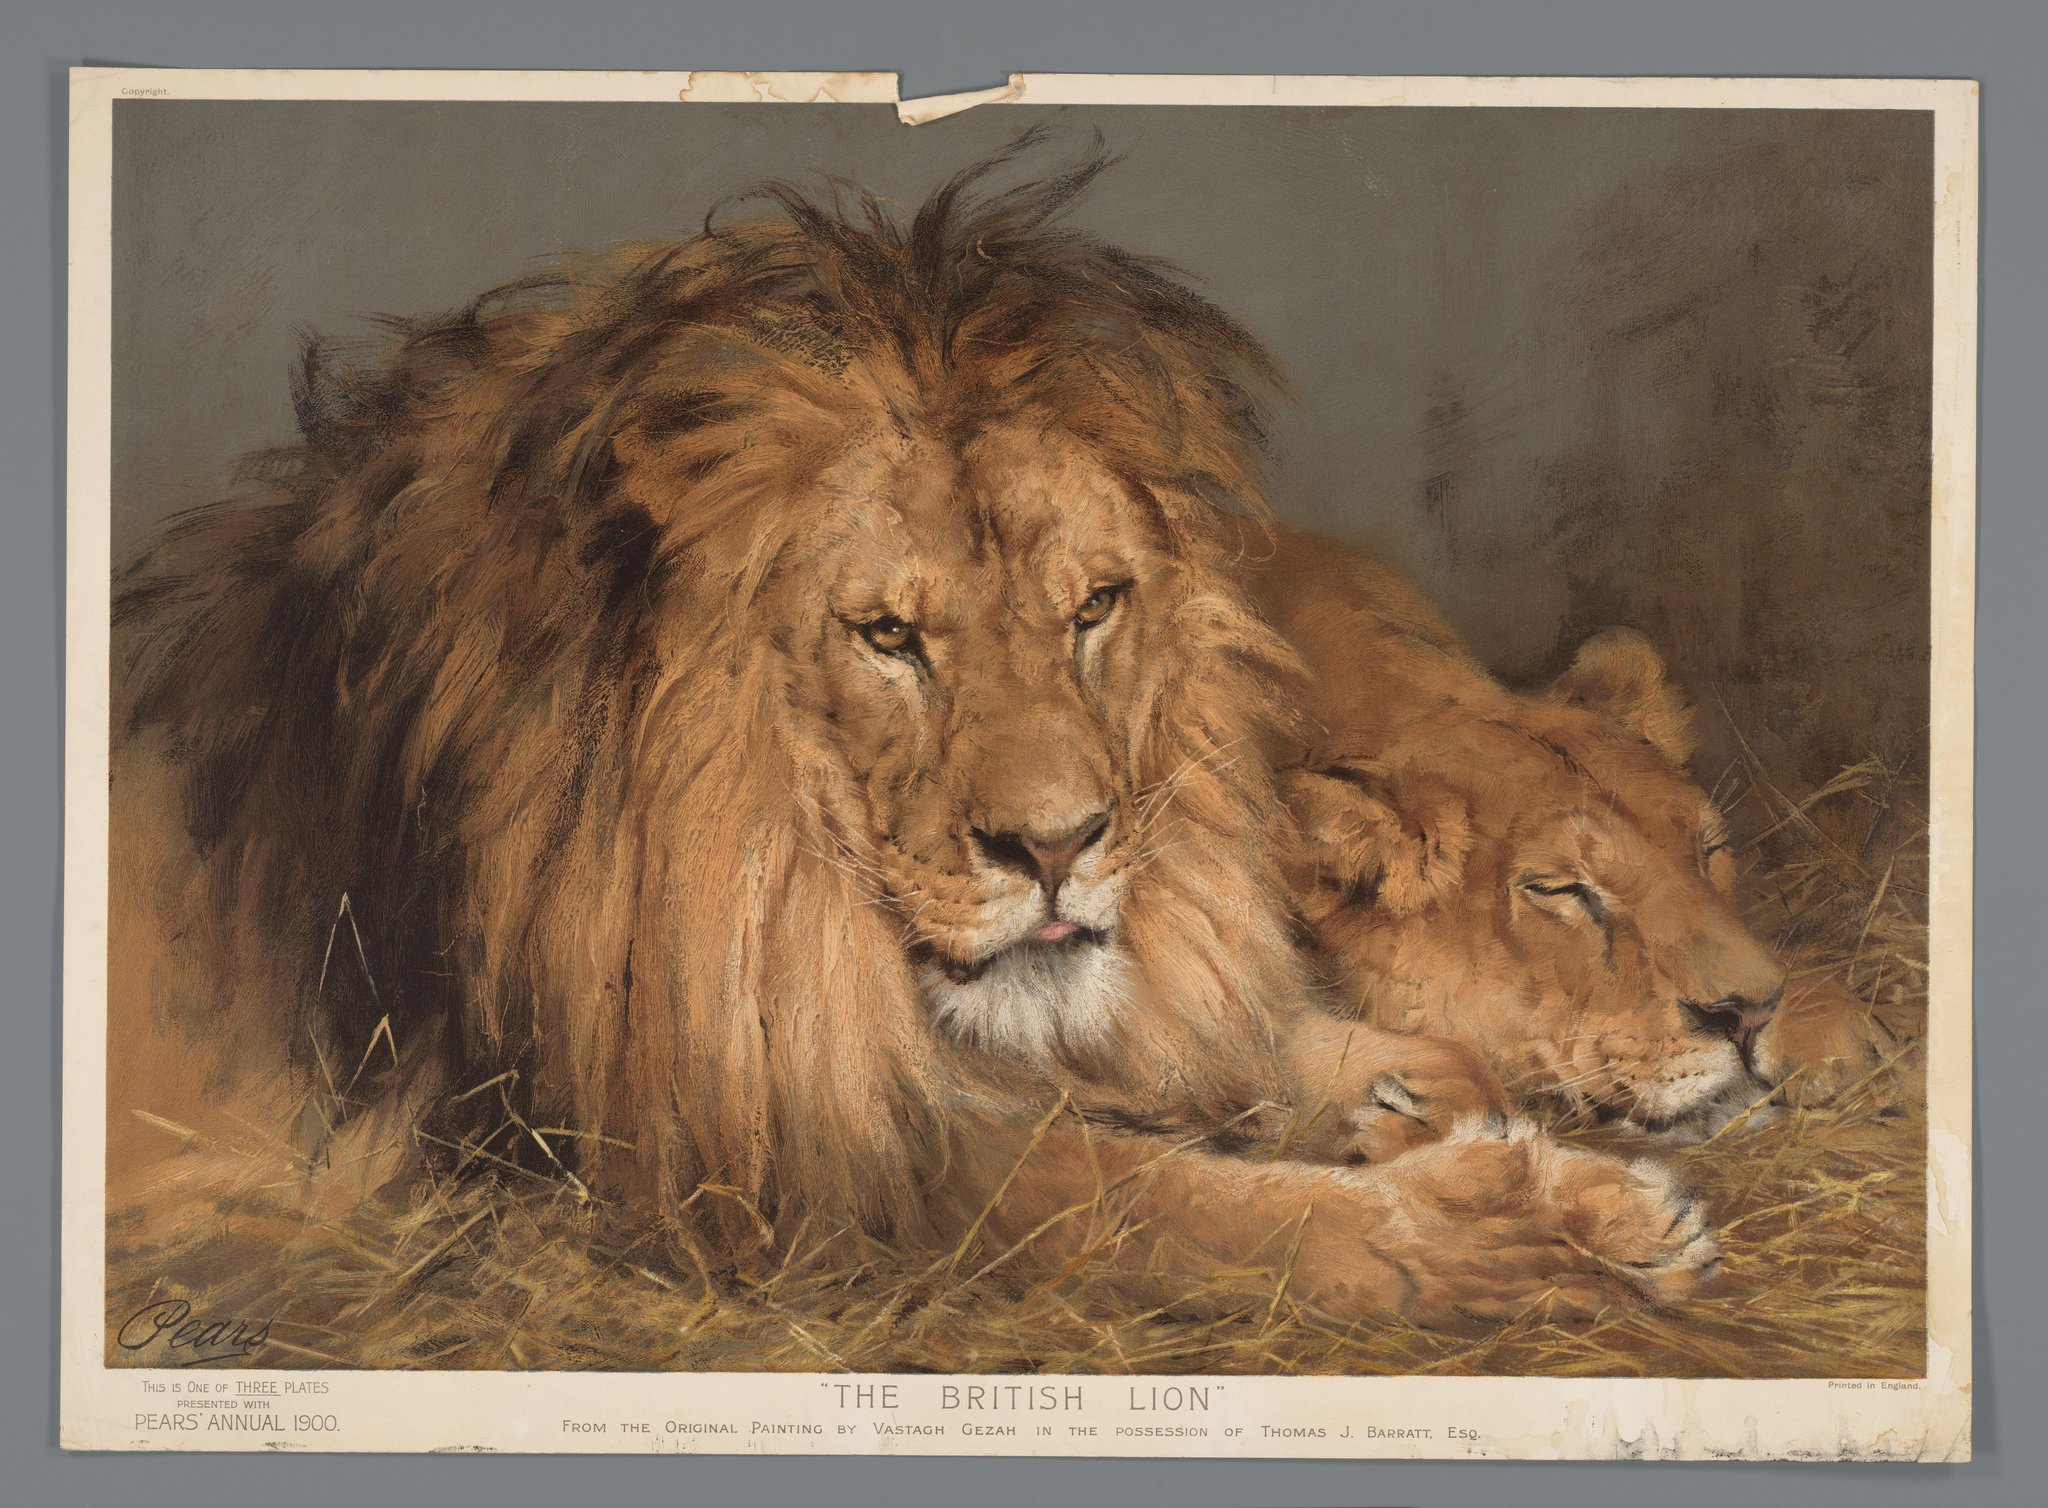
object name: reproduction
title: The British lion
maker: géza vastagh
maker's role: painter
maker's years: 1866-1919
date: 1900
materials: paper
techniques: photolithography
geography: england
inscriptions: collector's mark